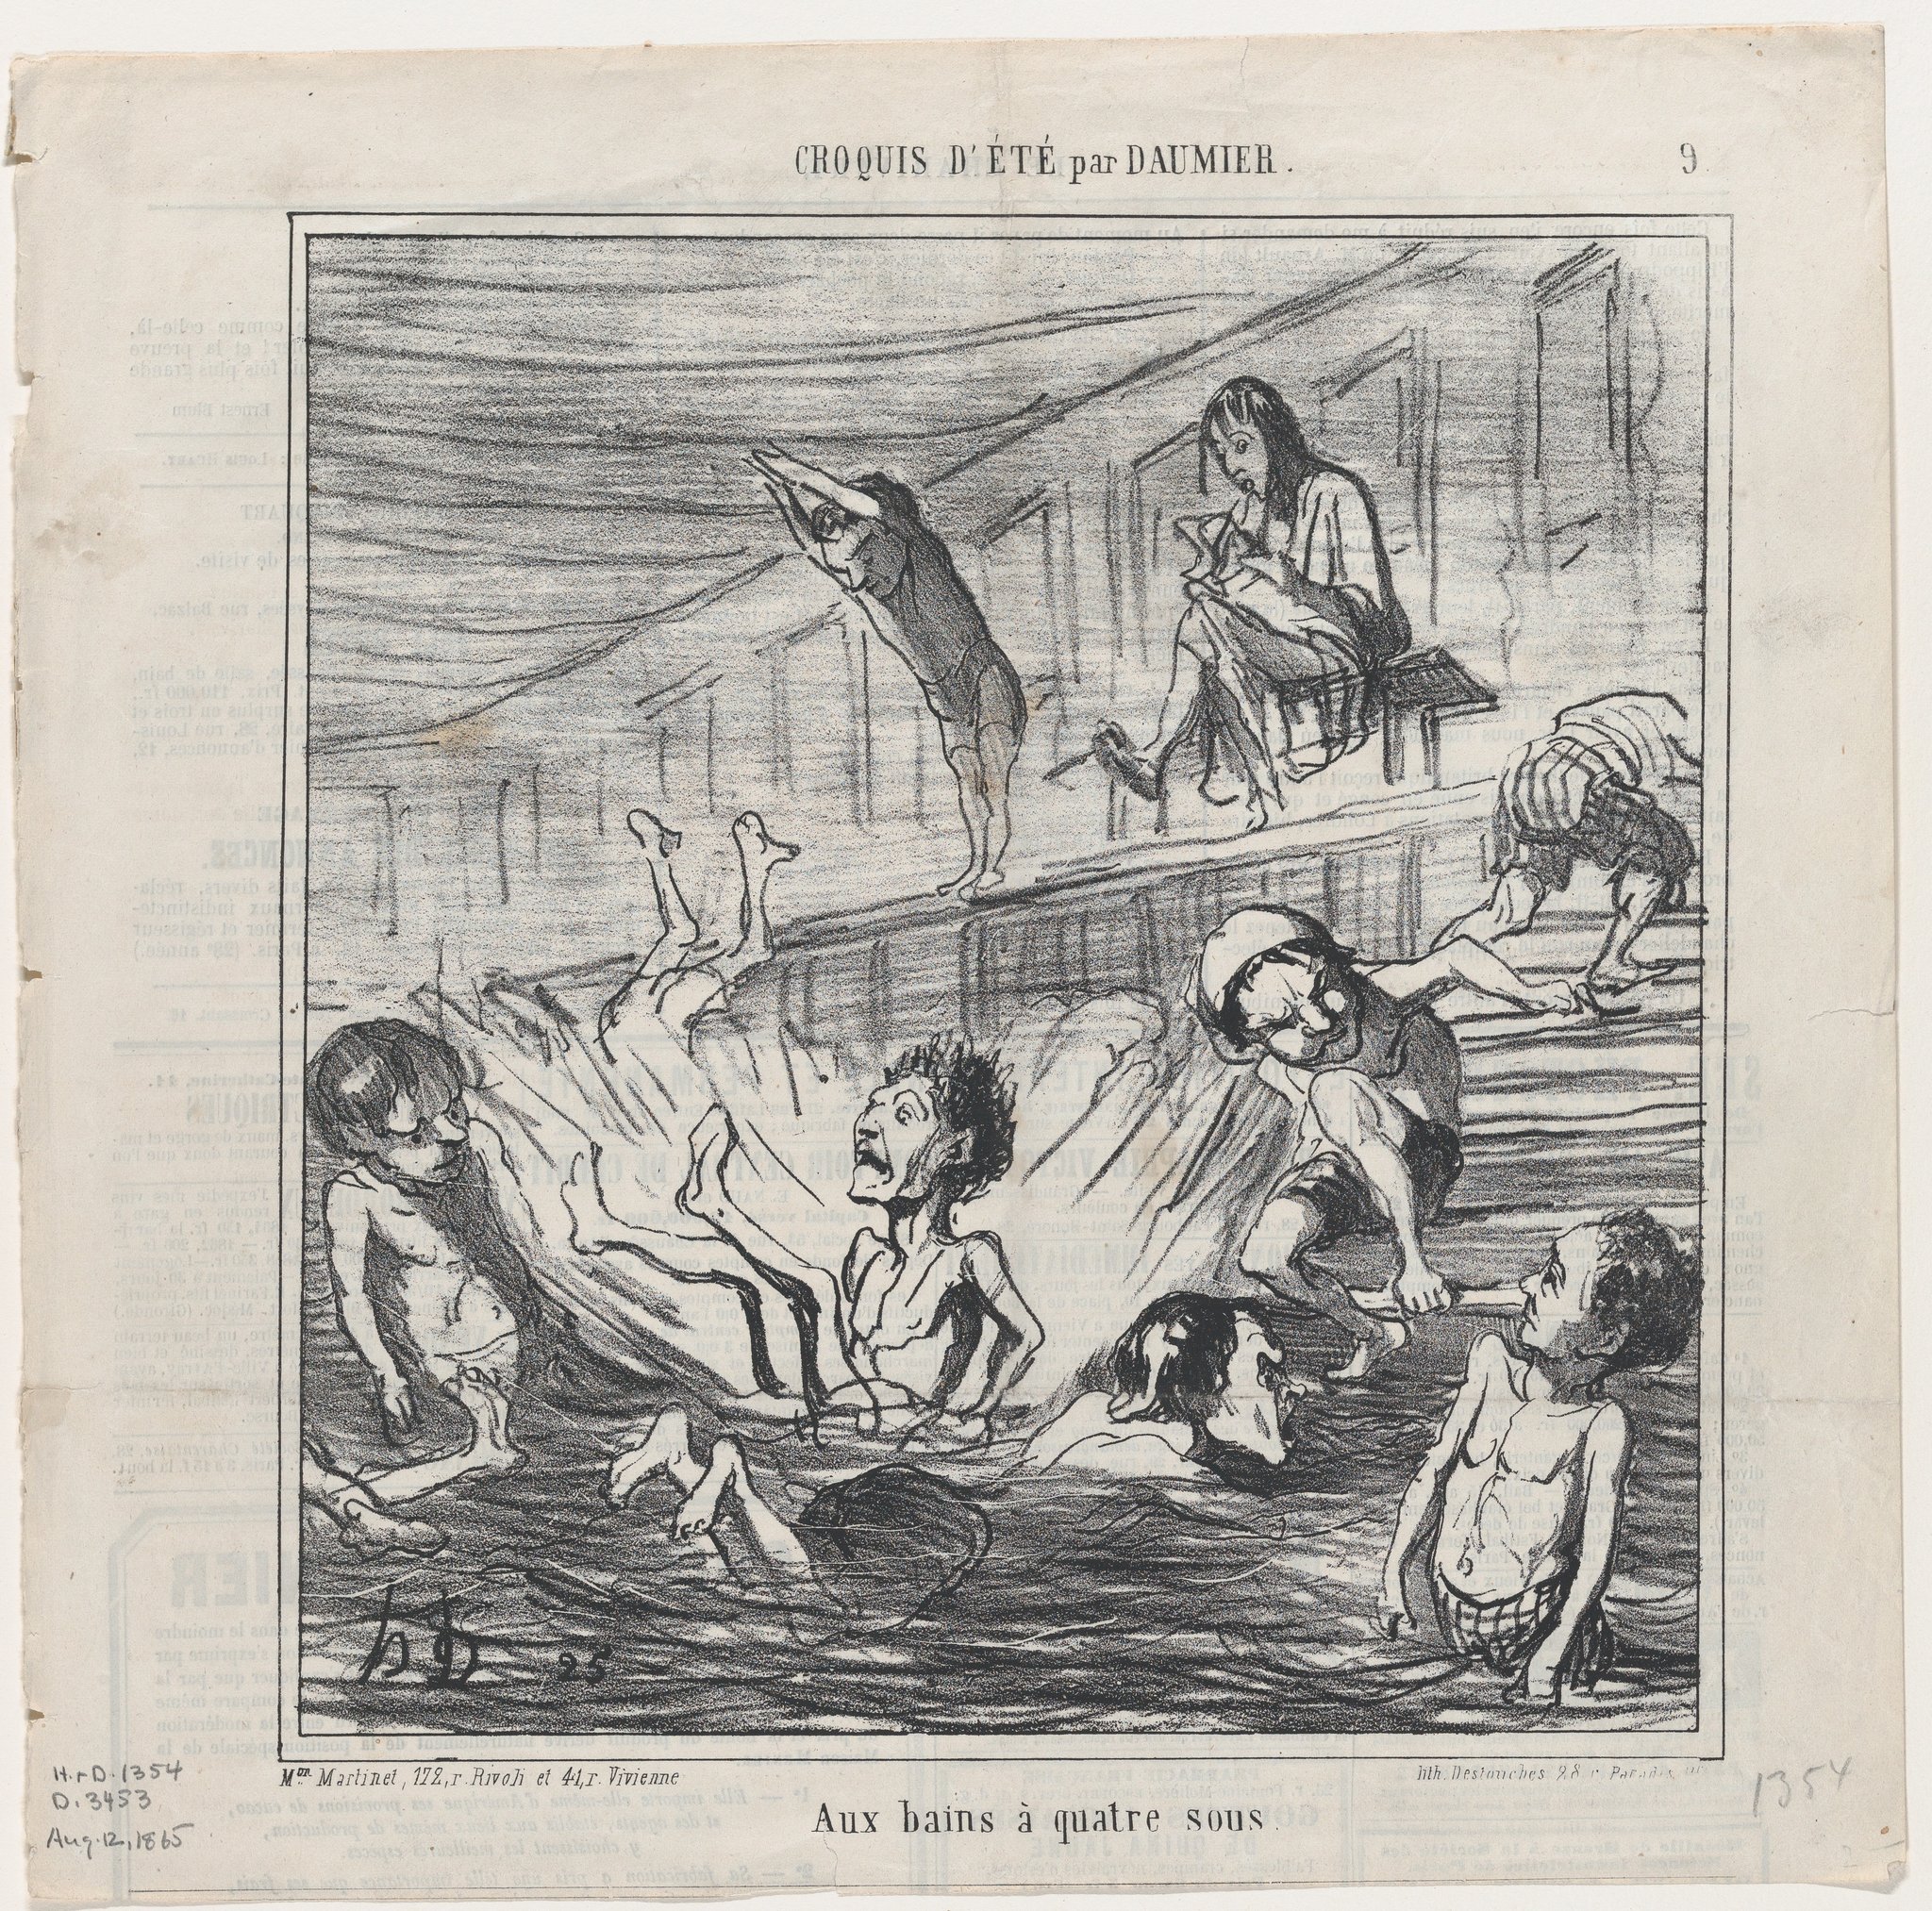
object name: print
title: At the four penny baths, from 'Summer sketches,' published in Le Charivari, August 12, 1865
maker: honoré daumier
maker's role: artist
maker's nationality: french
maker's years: 1808-1879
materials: paper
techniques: lithograph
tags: men,women,bathing